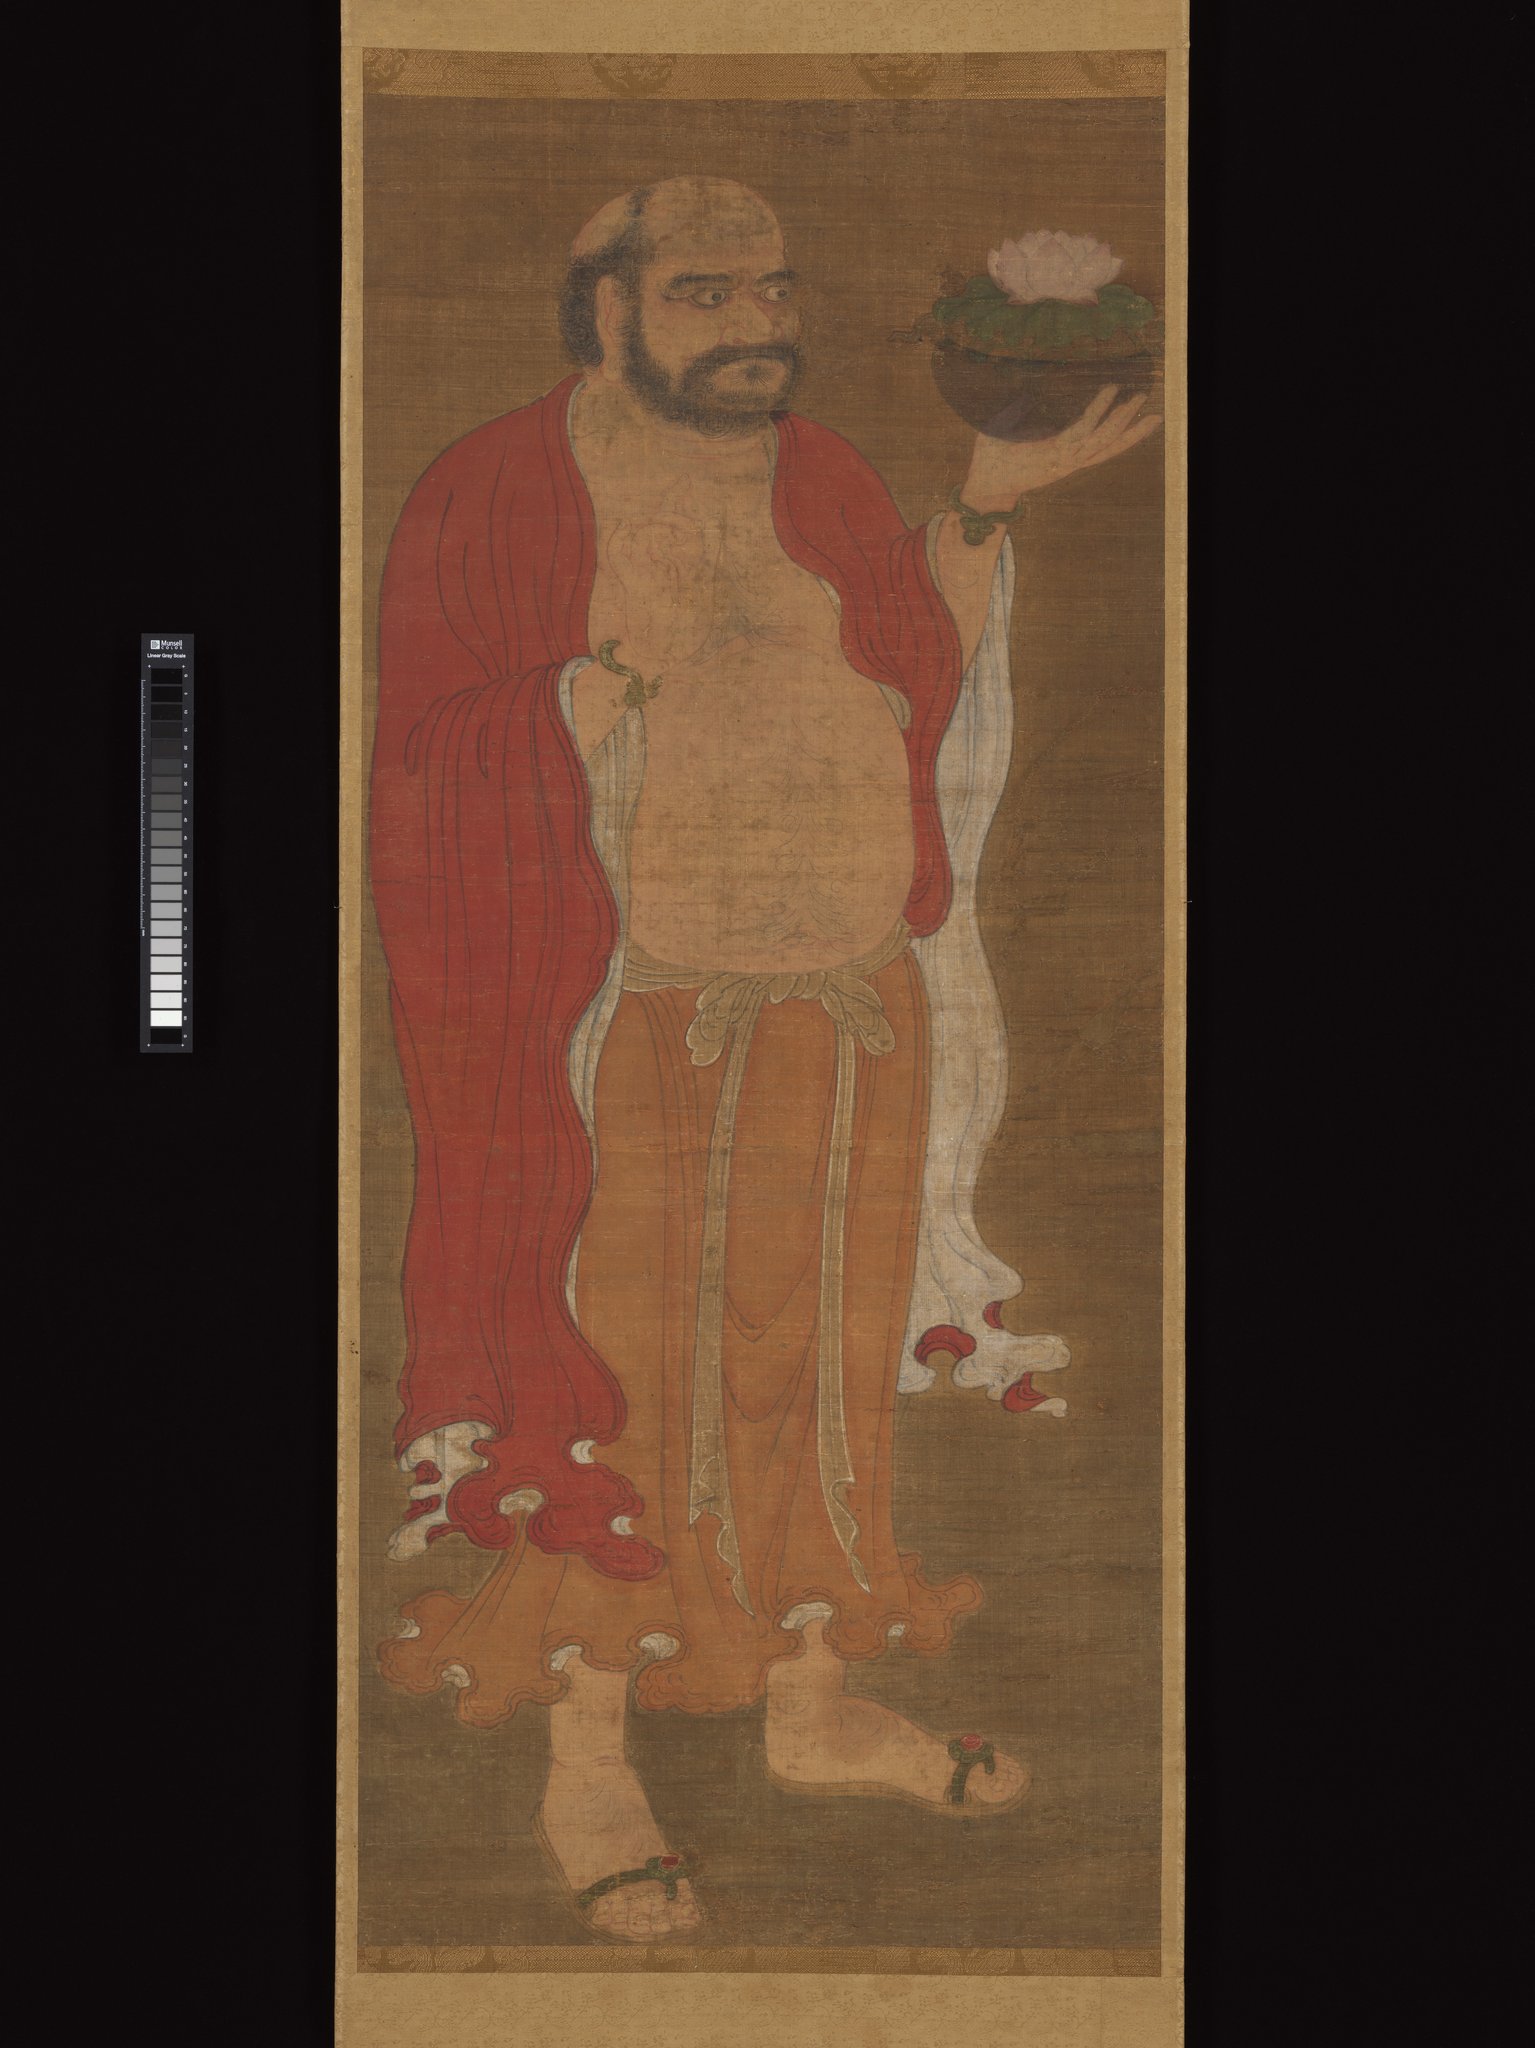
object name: hanging scroll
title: Luohan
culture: chinese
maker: unidentified artist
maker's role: artist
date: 1267-1333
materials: ink, silk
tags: men,lotuses